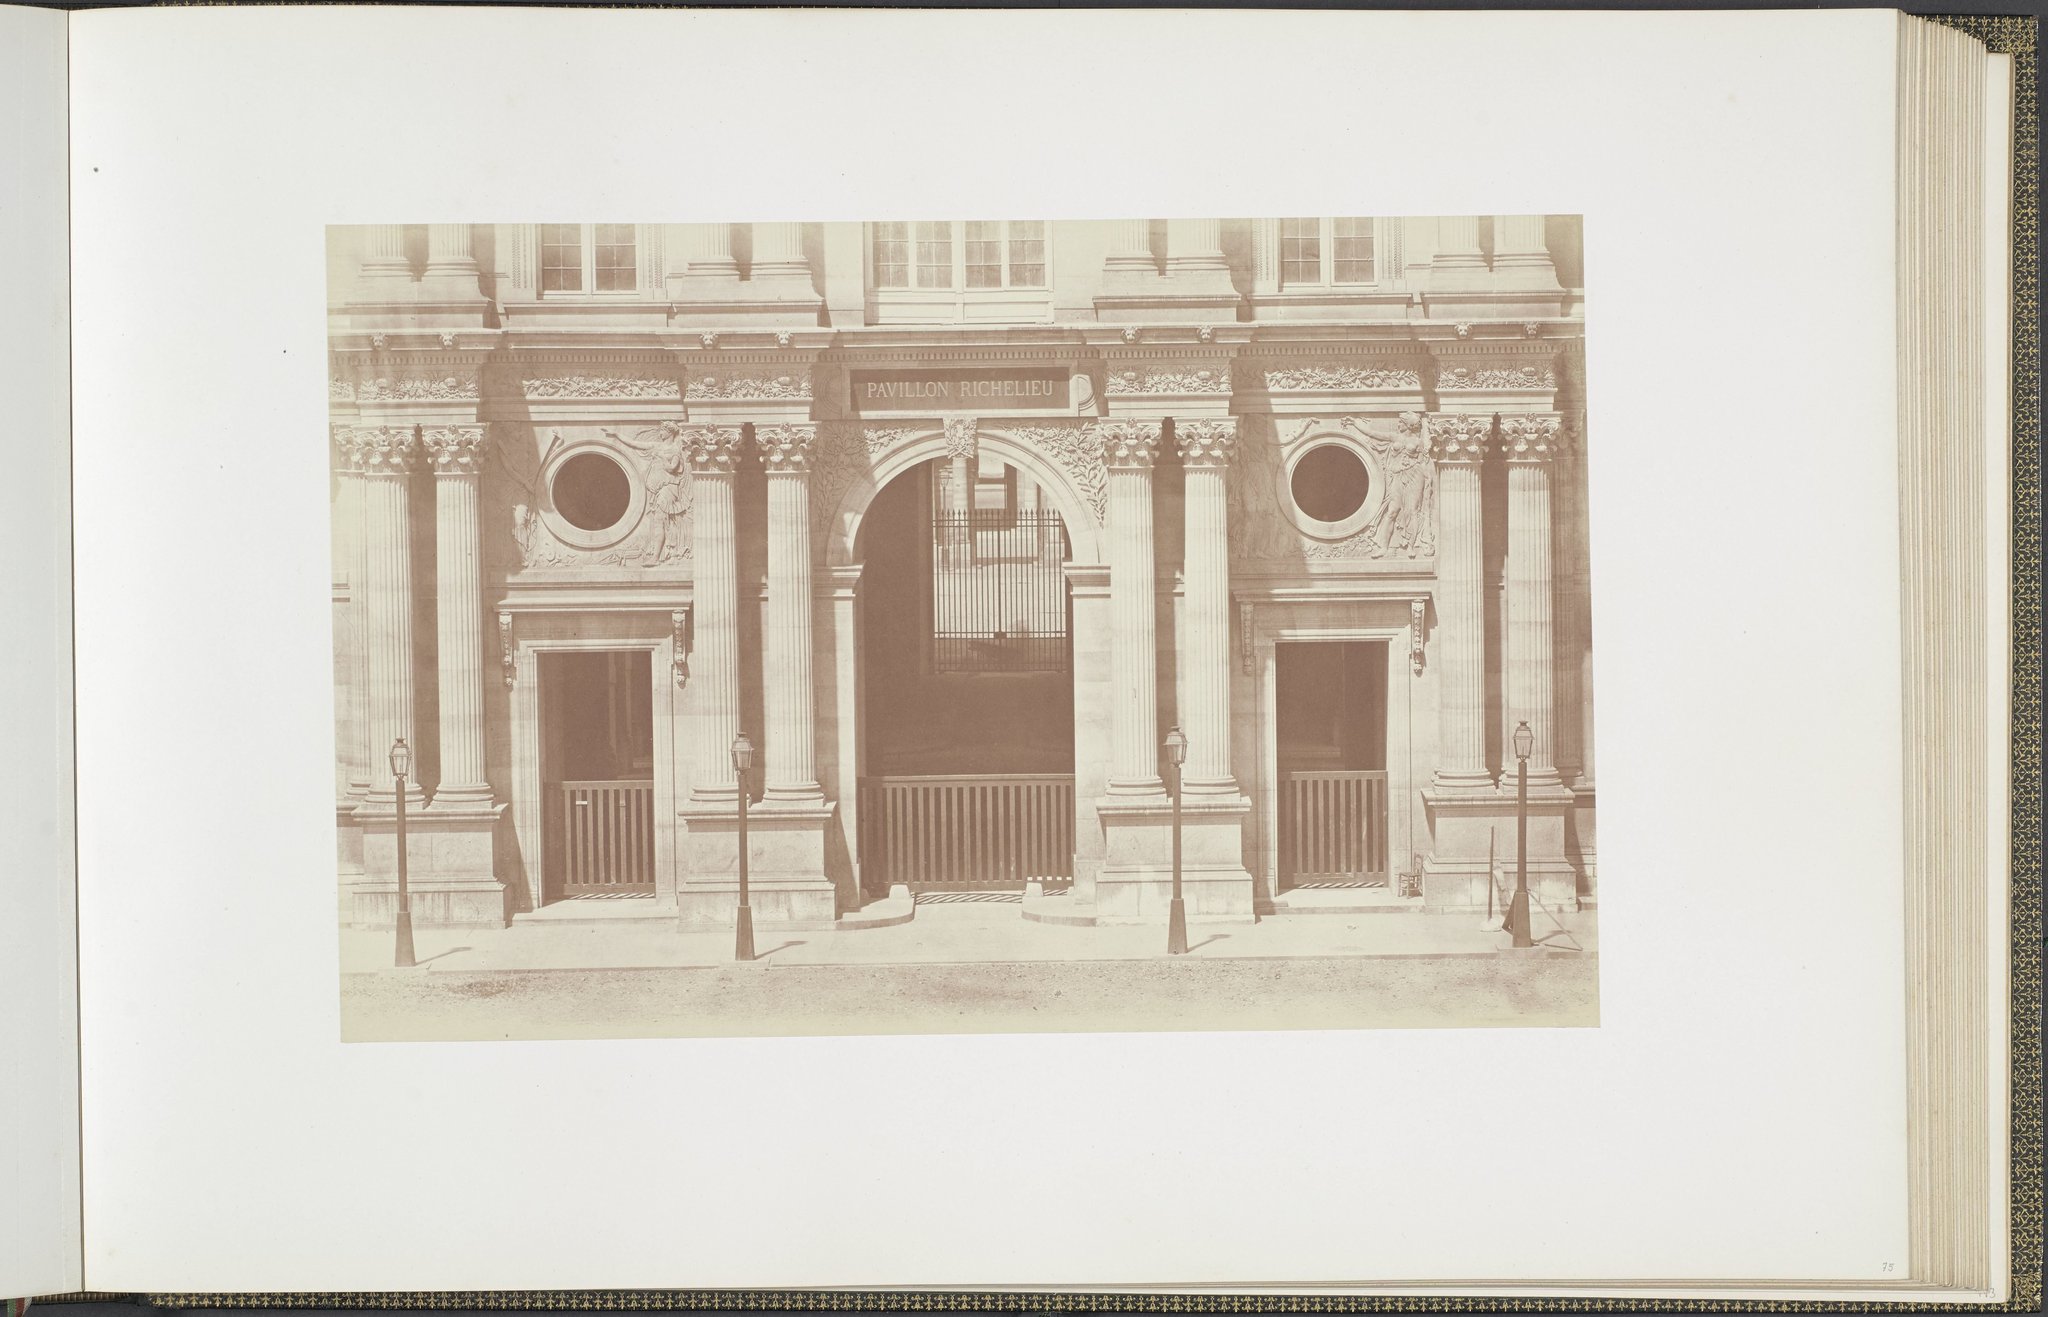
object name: album leaf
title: Begane grond van het Pavillon Richelieu in het Palais du Louvre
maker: édouard denis baldus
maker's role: fotograaf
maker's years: 1813-1889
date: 1857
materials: paper, photographic support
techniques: salted paper print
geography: paris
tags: gate, entrance, permanent exhibition, museum, façade (of house or building), paris, tuileries palace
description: Onderdeel van Réunion des Tuileries au Louvre 1852-1857, album 1.